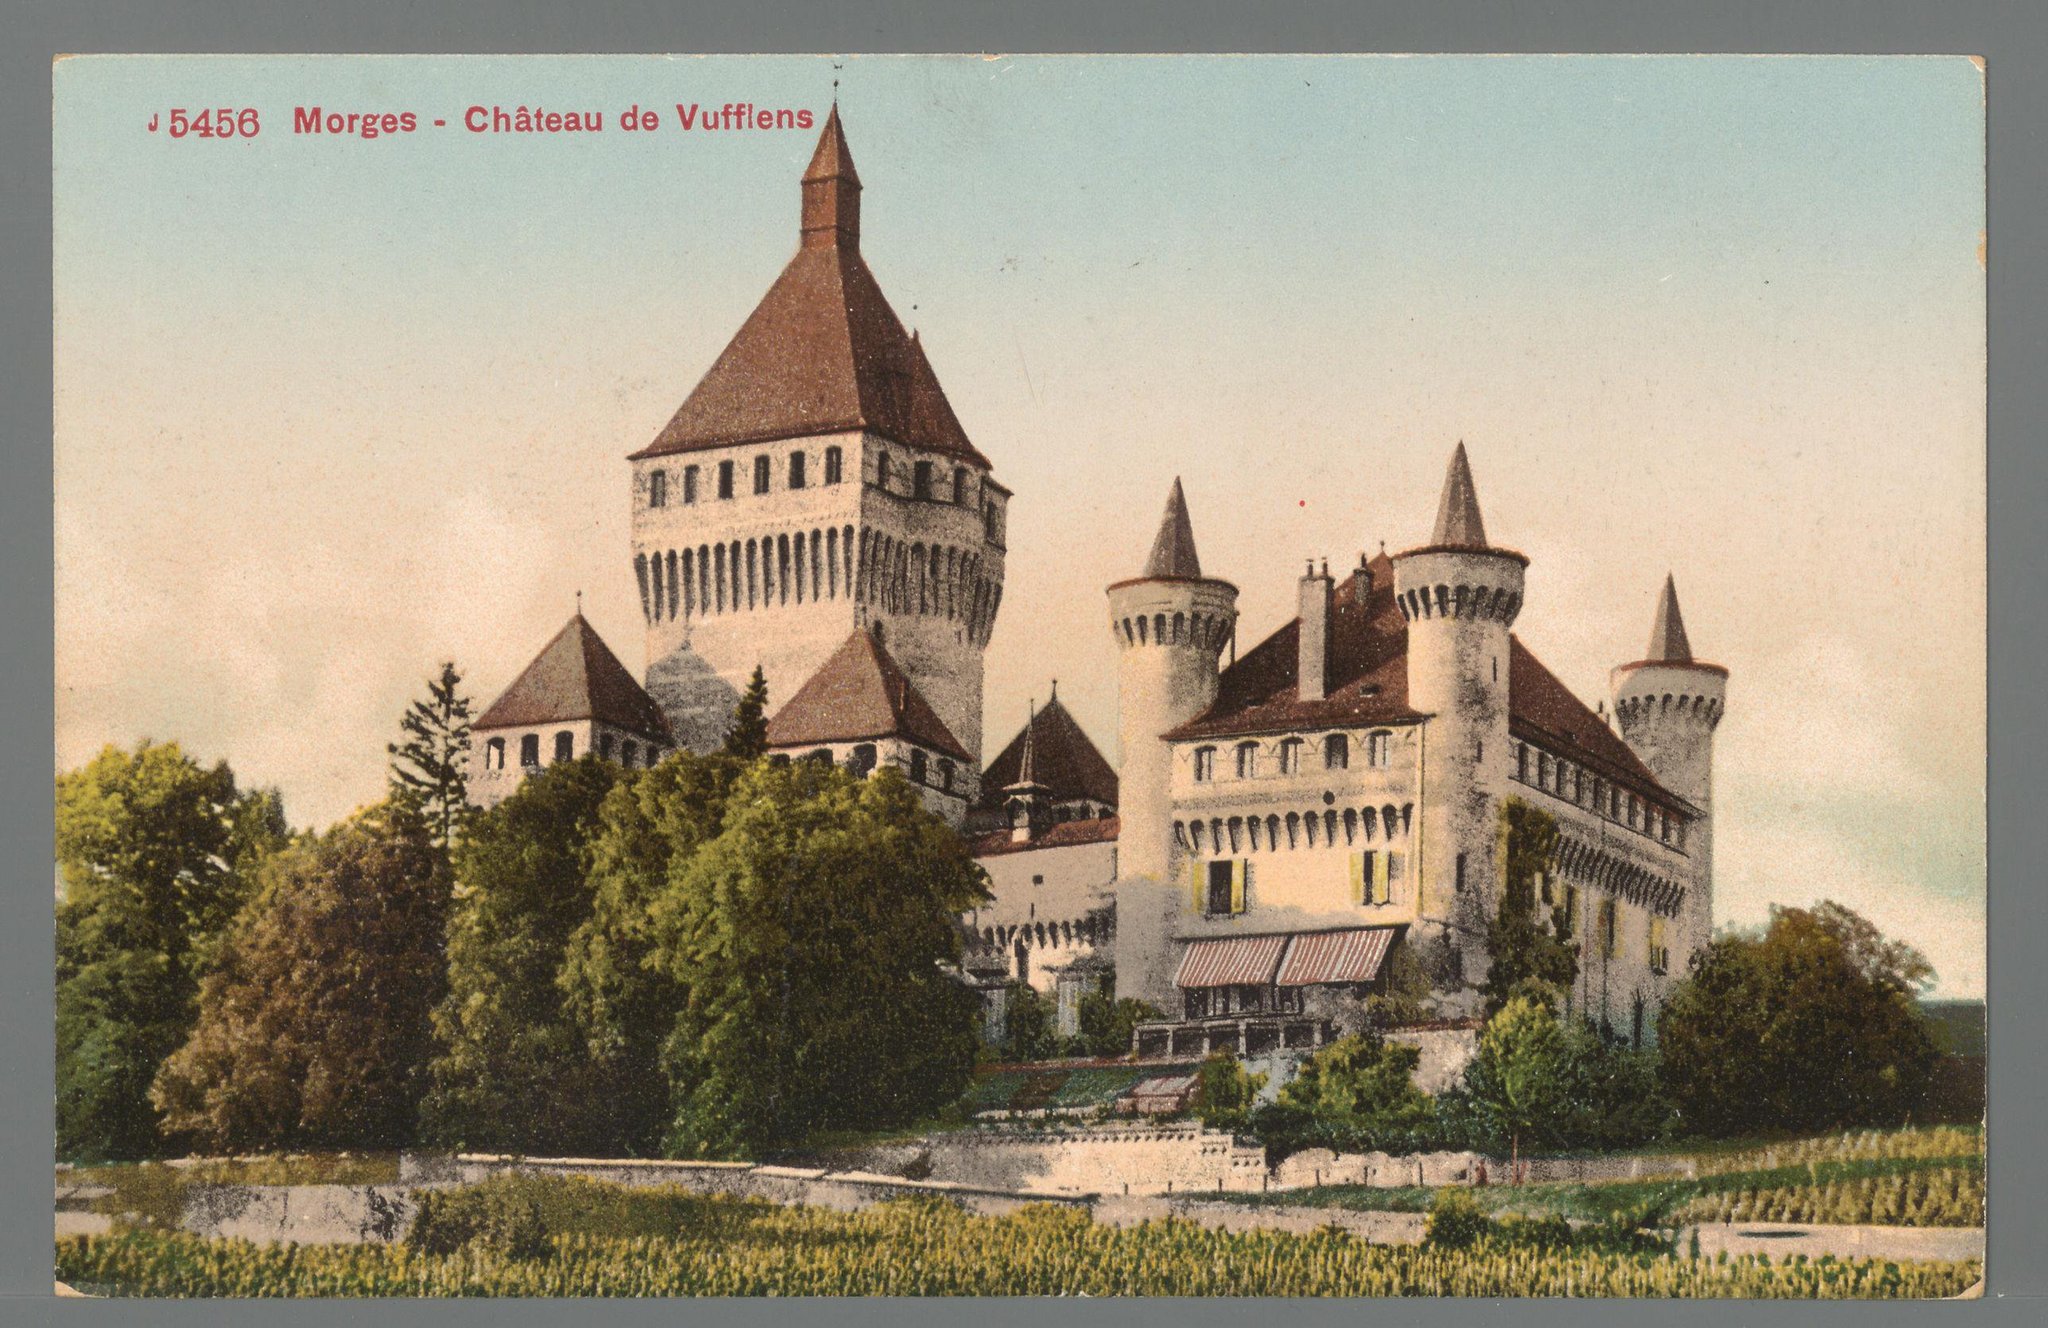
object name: photomechanical print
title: Morges. Château de Vufflens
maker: Anonymous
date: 1905-1920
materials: cardboard, photographic process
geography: zurich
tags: castle